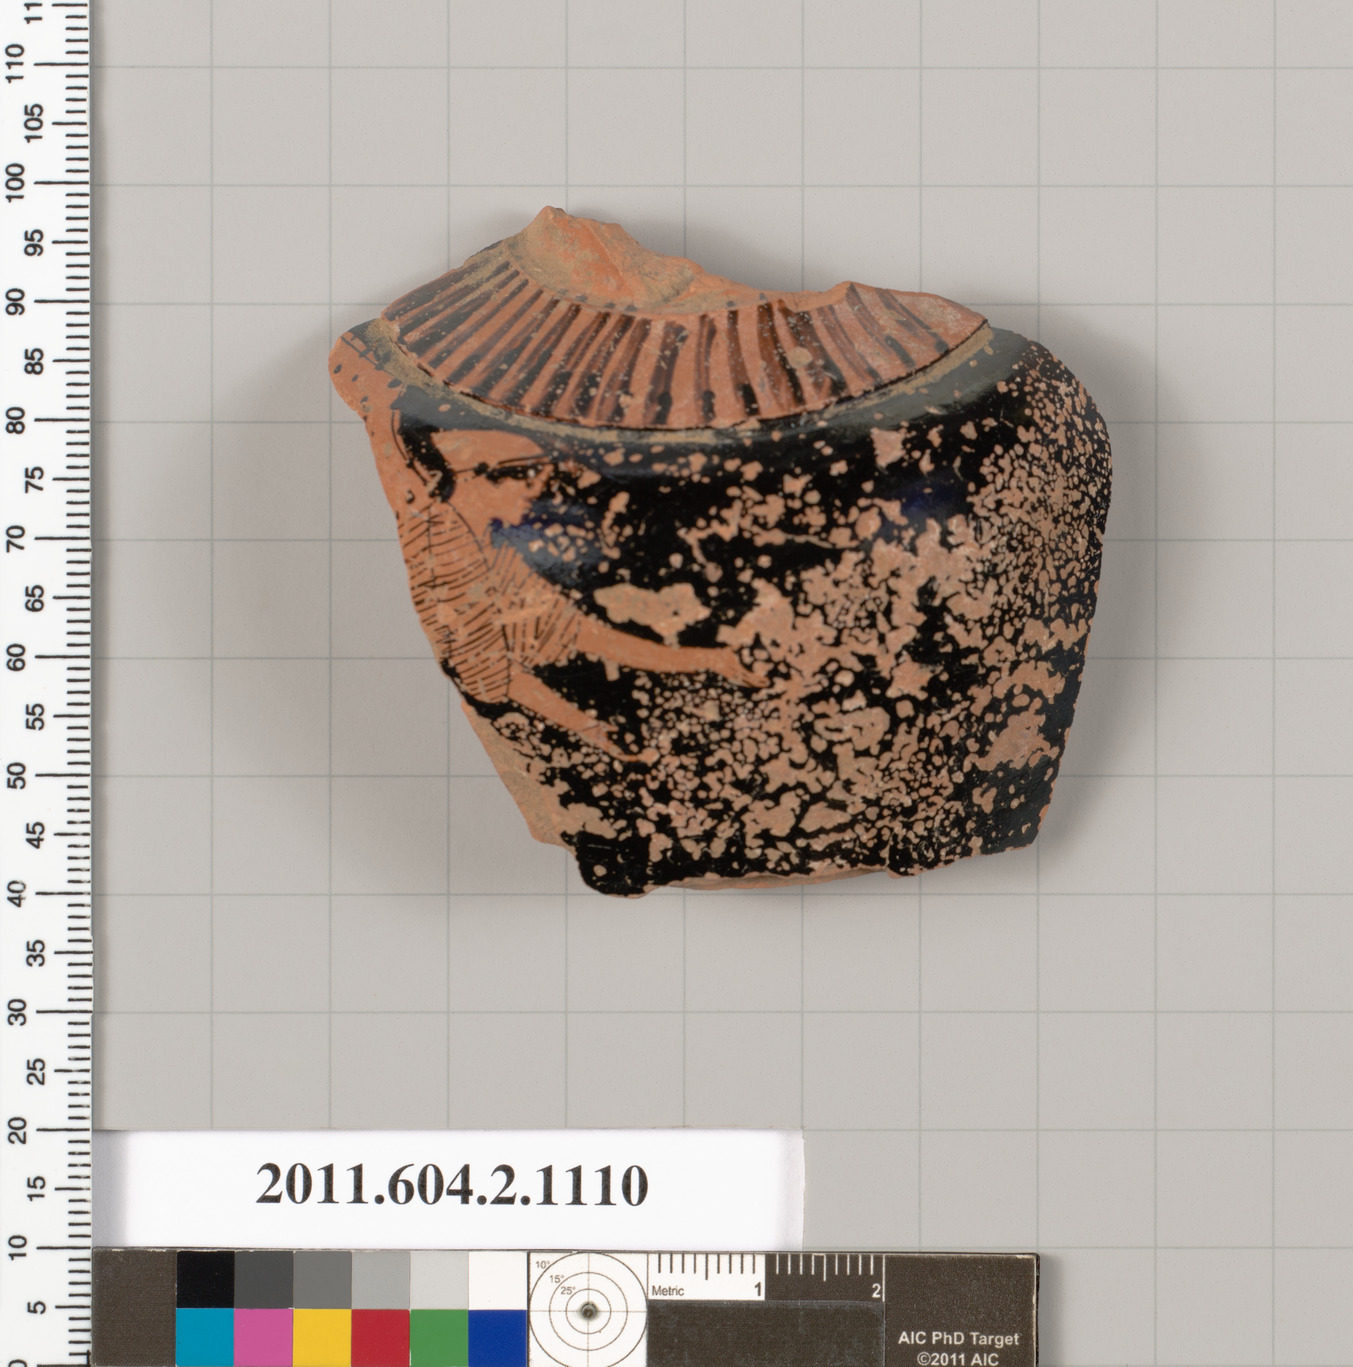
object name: lekythos fragment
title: Terracotta fragment of a squat lekythos (oil flask)?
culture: greek, attic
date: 460-450 BCE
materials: terracotta